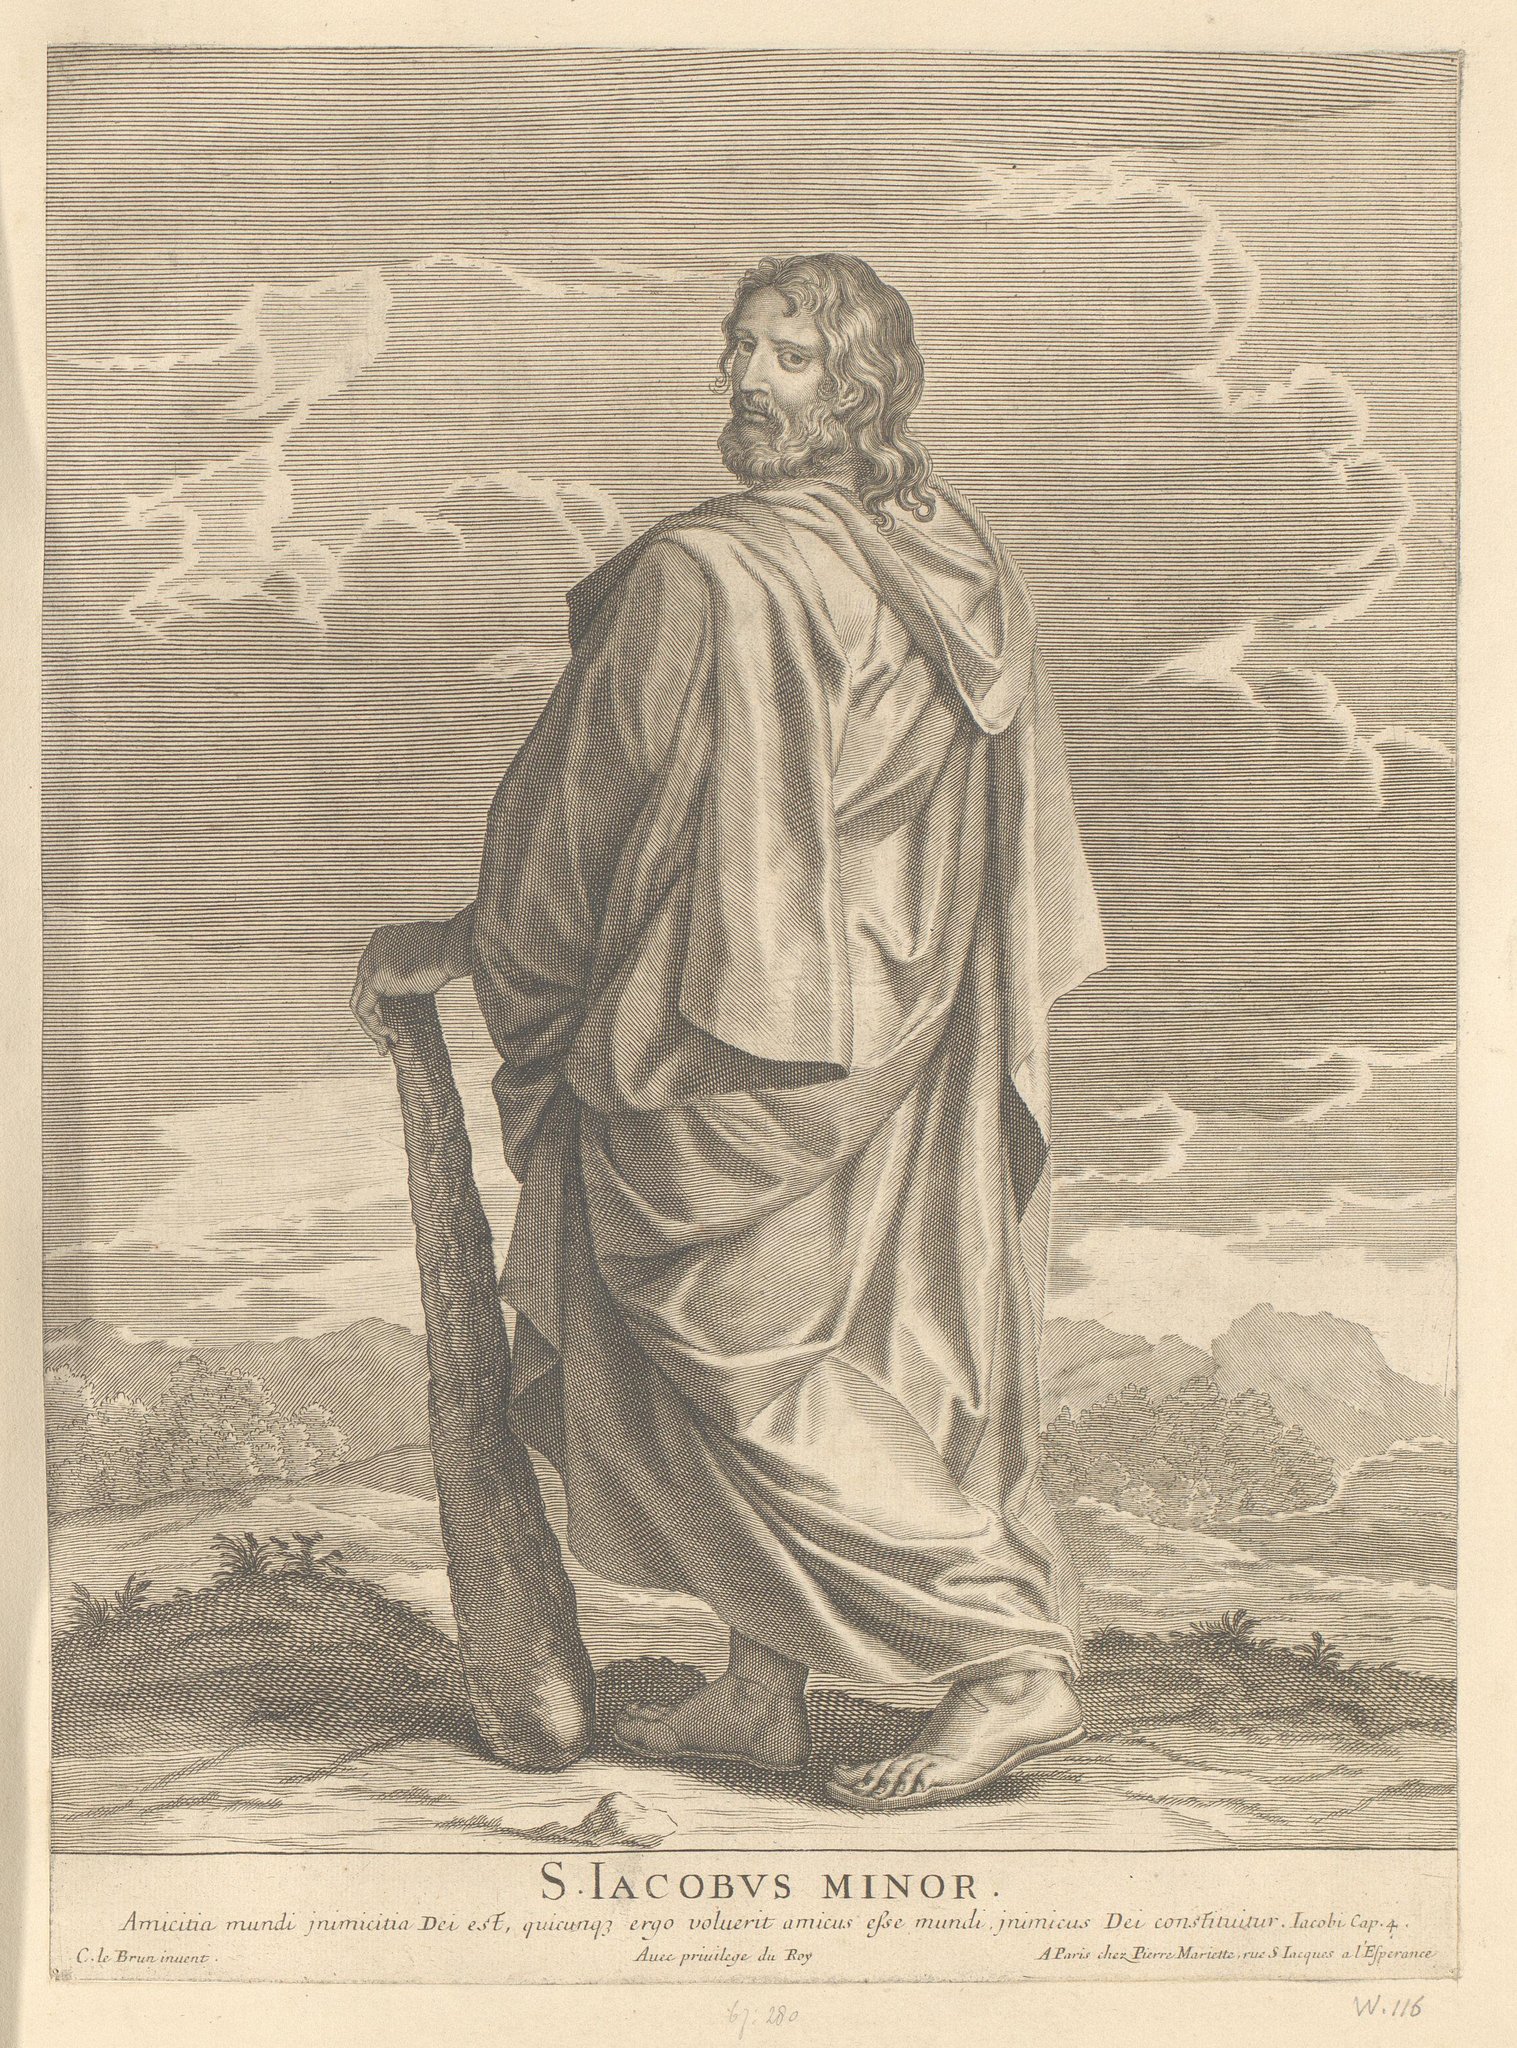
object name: album leaf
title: Apostelen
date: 1650-1700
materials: paper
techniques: engraving, etching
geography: paris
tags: the apostle james the less, first bishop of jerusalem; possible attributes: book, fuller's club, scroll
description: Deze prent maakt deel uit van een album.